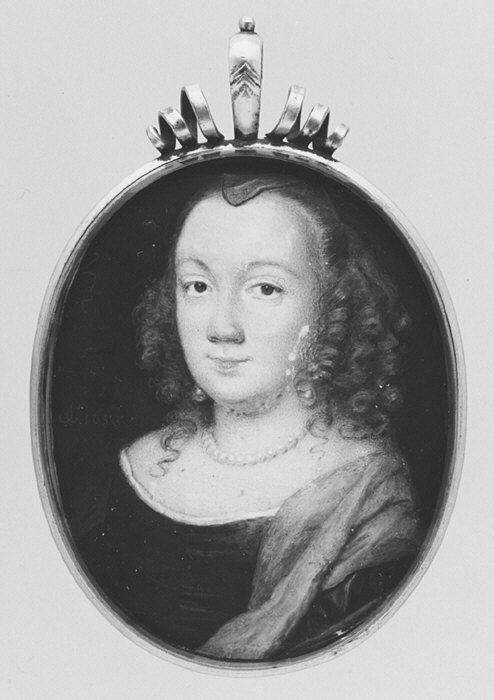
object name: painting, miniature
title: Portrait of a Woman, Said to Be Lucy Percy (1600?–1660), Countess of Carlisle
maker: samuel cooper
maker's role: artist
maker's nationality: british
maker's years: 1608-1672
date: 1653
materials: parchment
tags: portraits,women